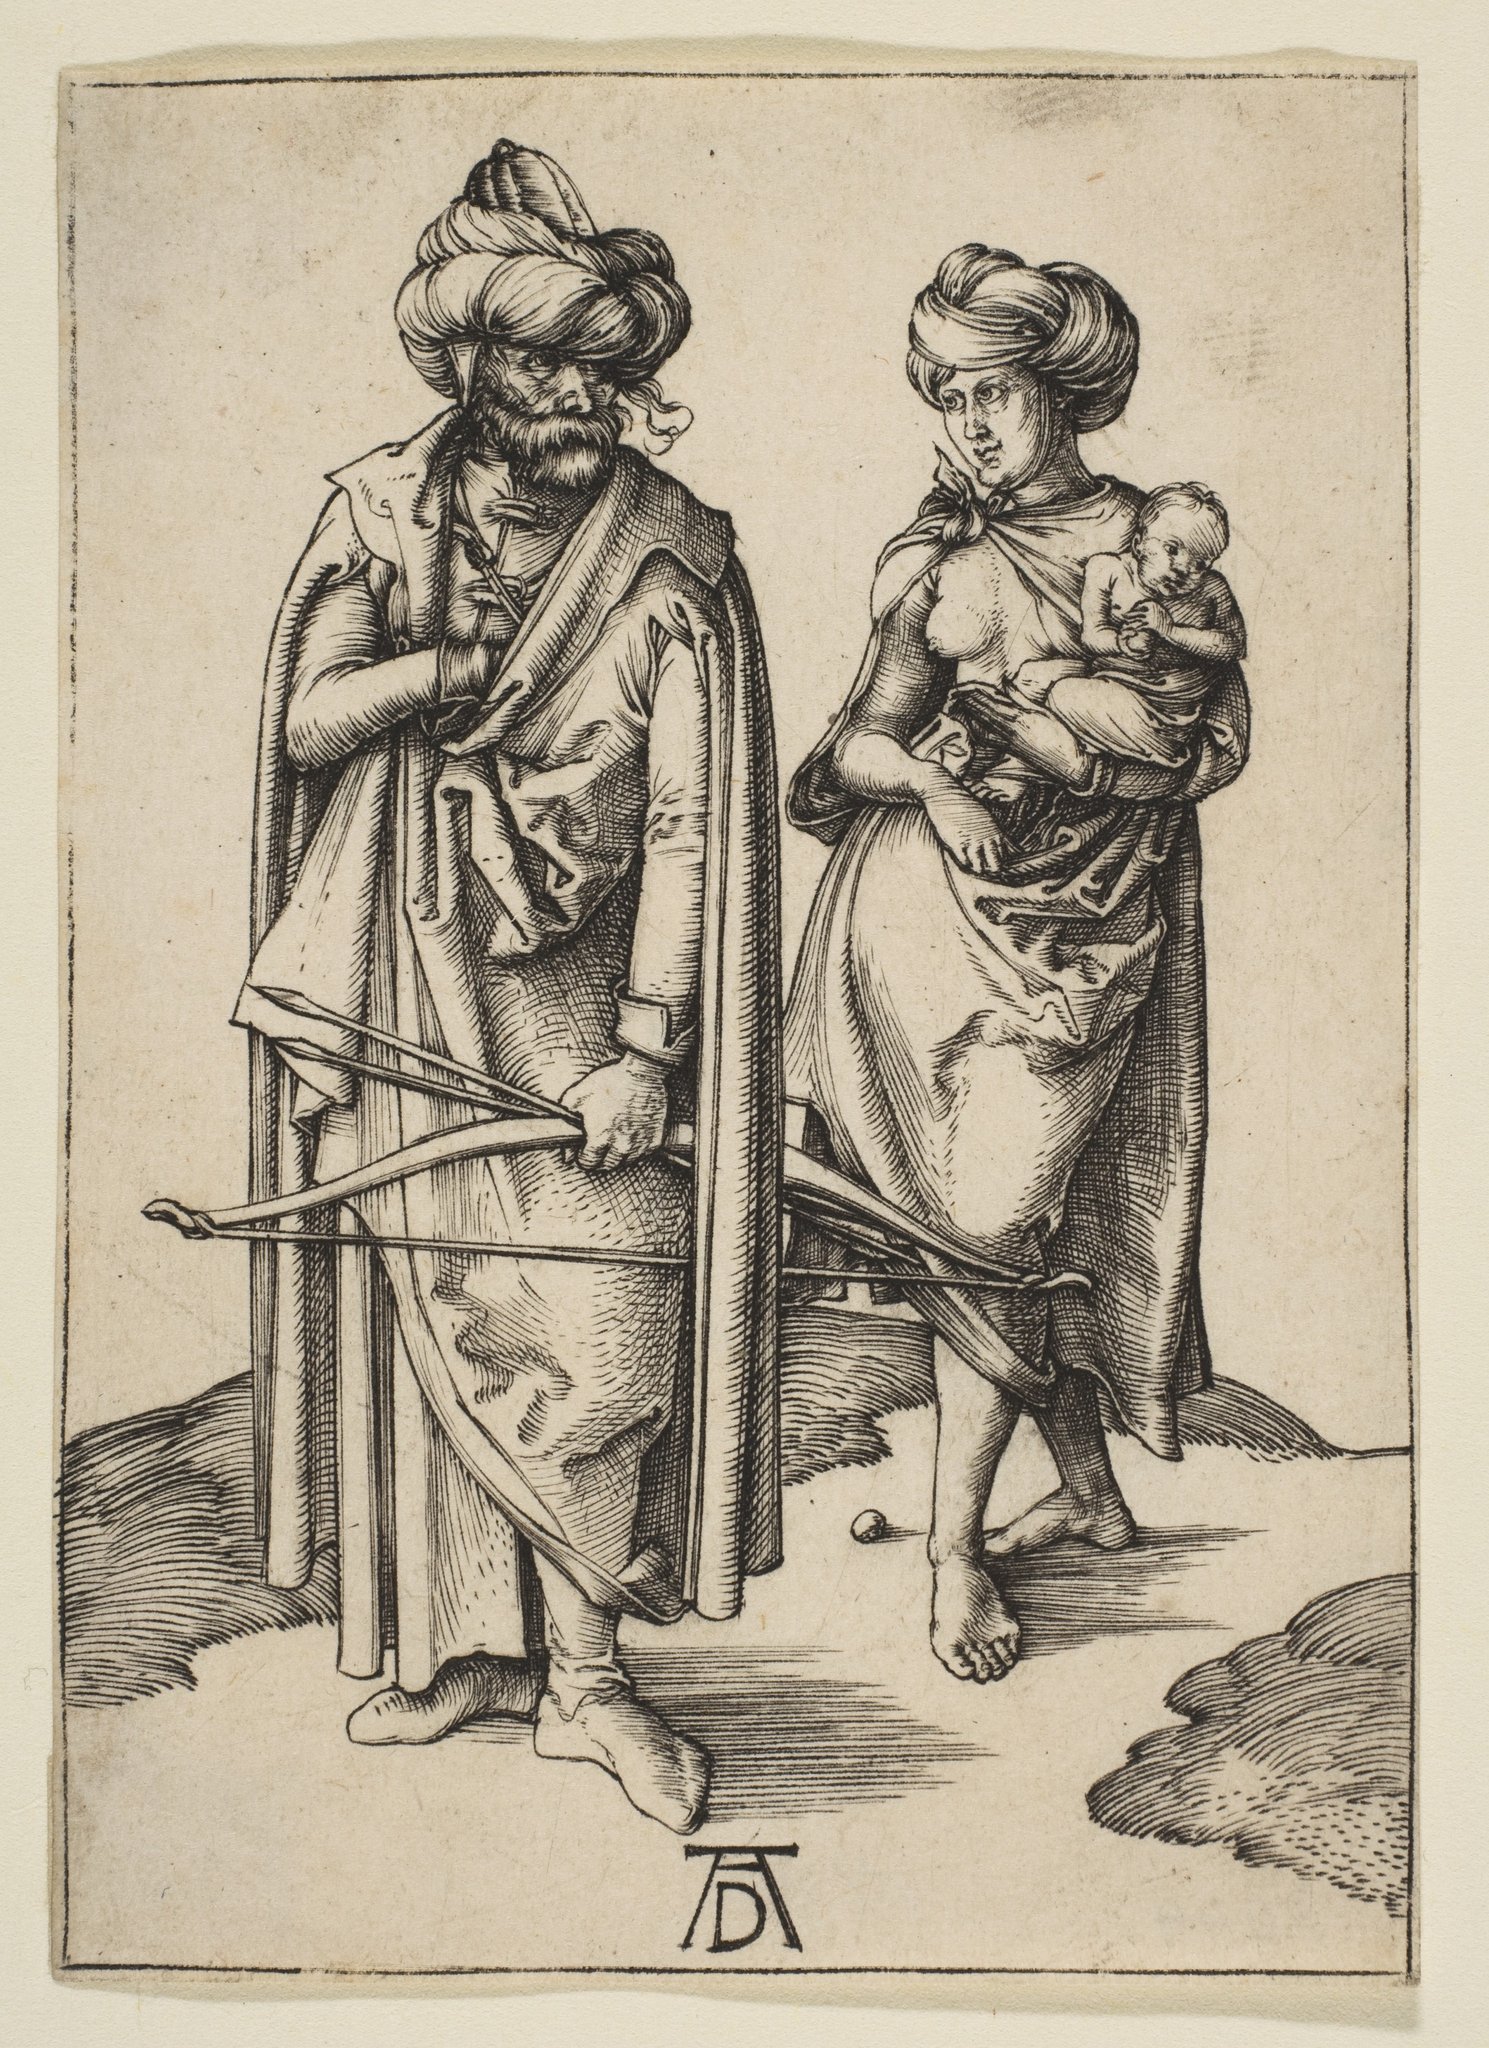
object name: print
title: The Turkish Family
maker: albrecht dürer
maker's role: artist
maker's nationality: german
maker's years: 1471-1528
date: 1496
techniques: engraving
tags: bow and arrow,infants,men,women,family